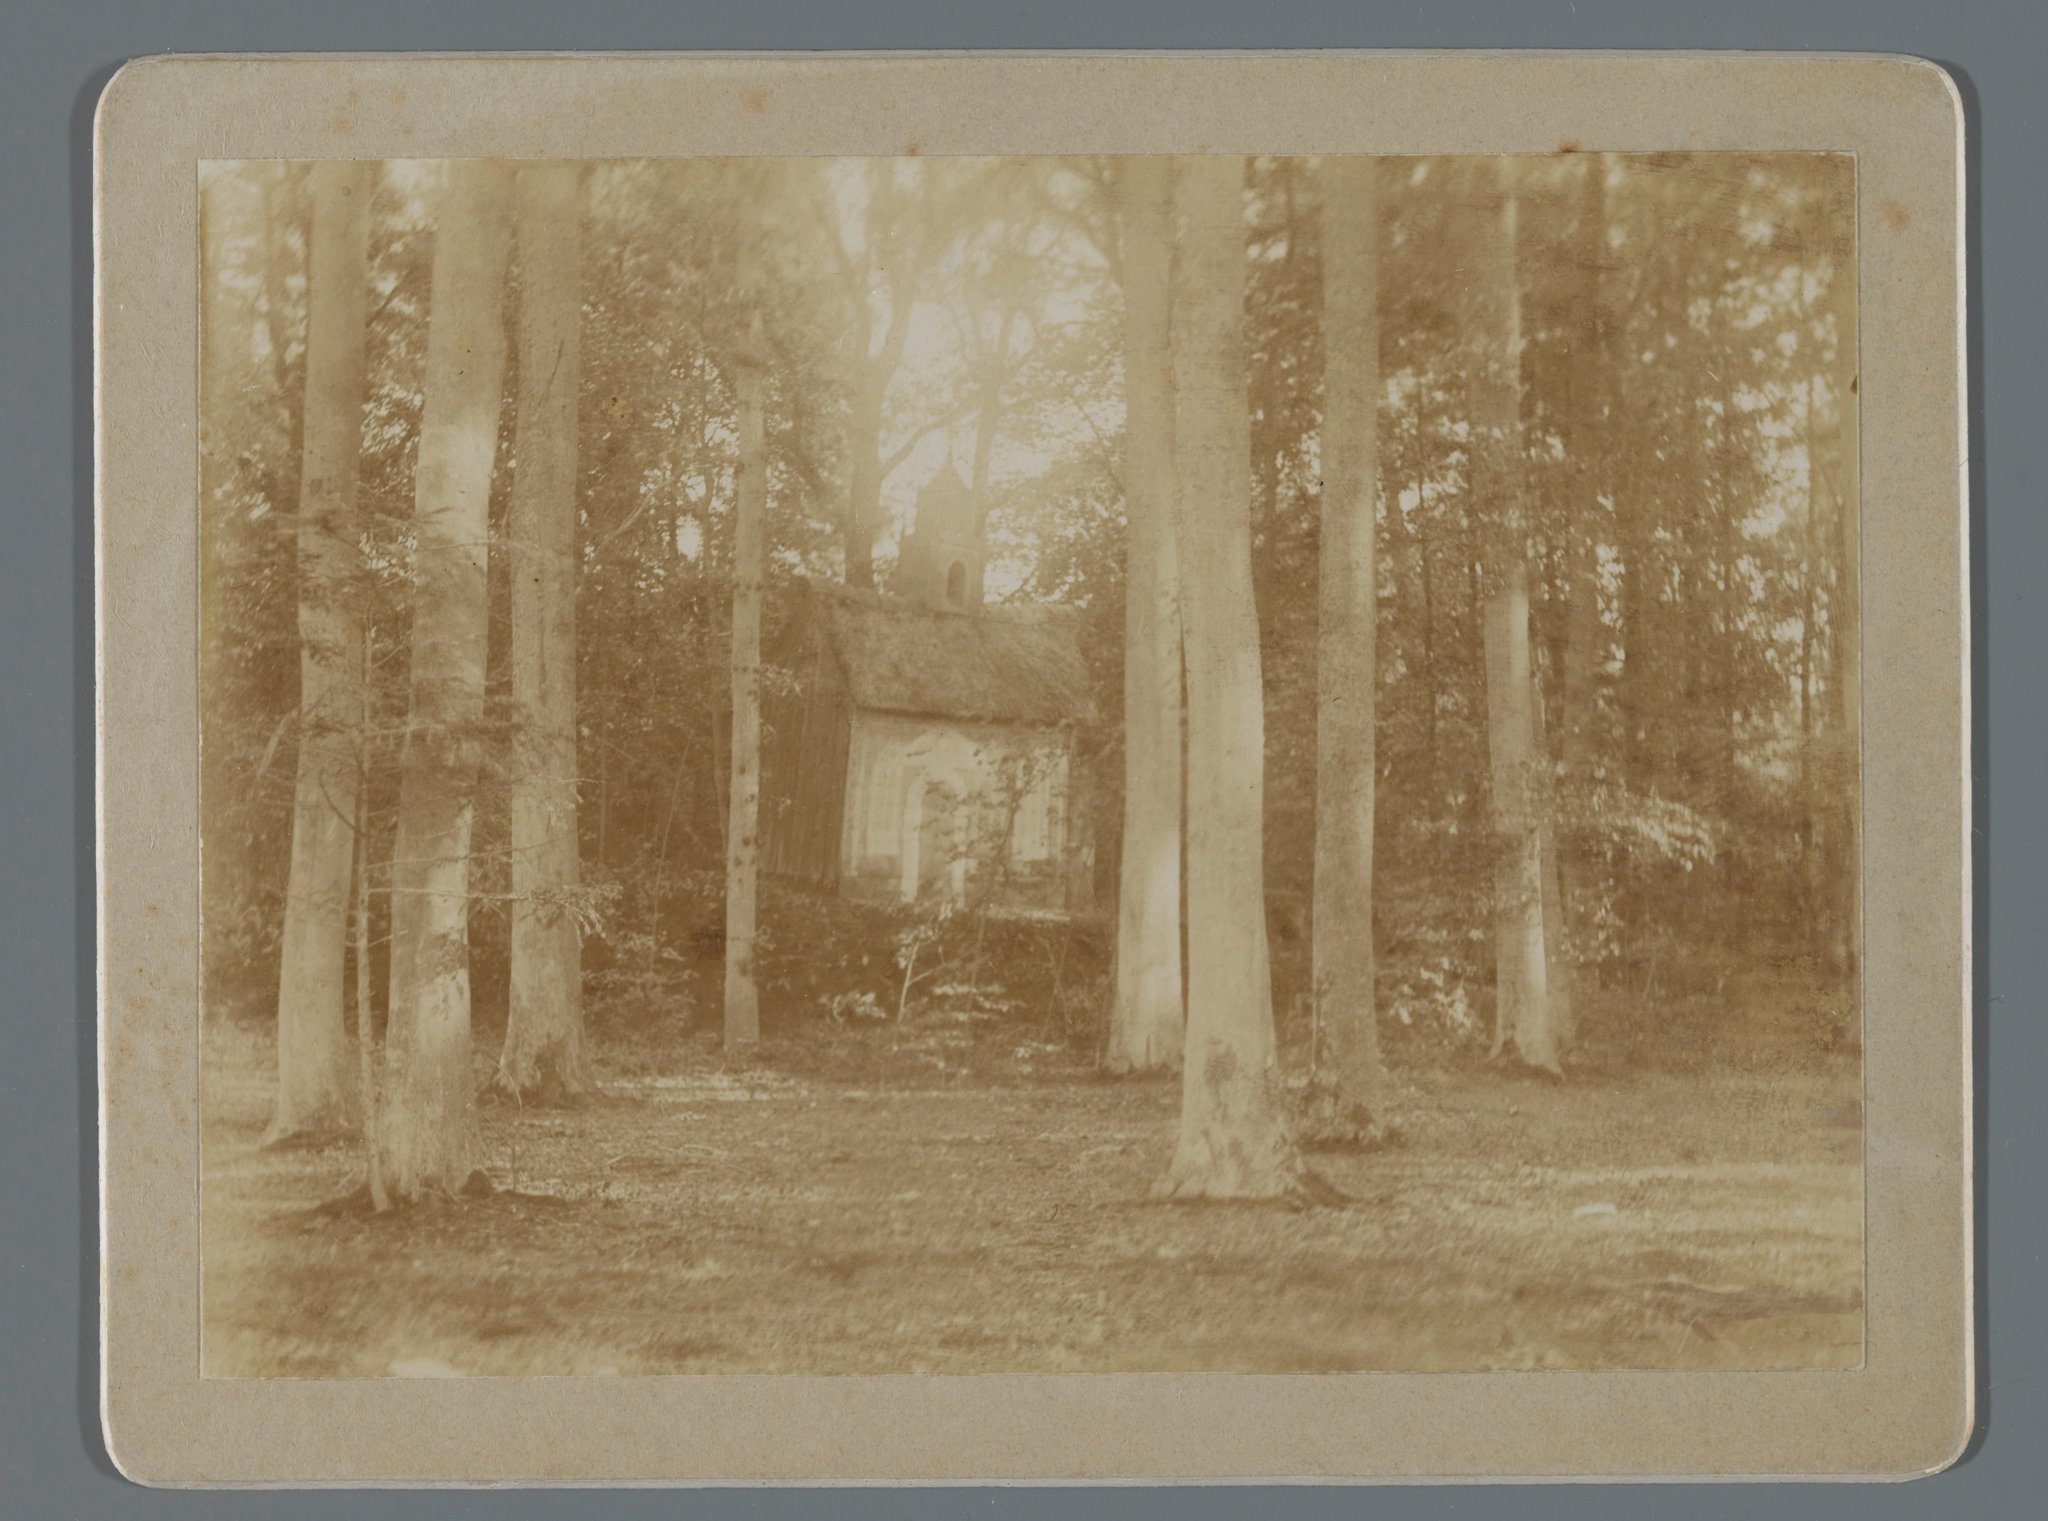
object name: photograph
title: Gezicht op een kapel in een bos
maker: cornelia hendrika jonker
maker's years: 1874-1924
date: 1880-1940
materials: cardboard, photographic support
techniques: collodion silver print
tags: forest, wood, church (exterior) - qq - small church, chapel